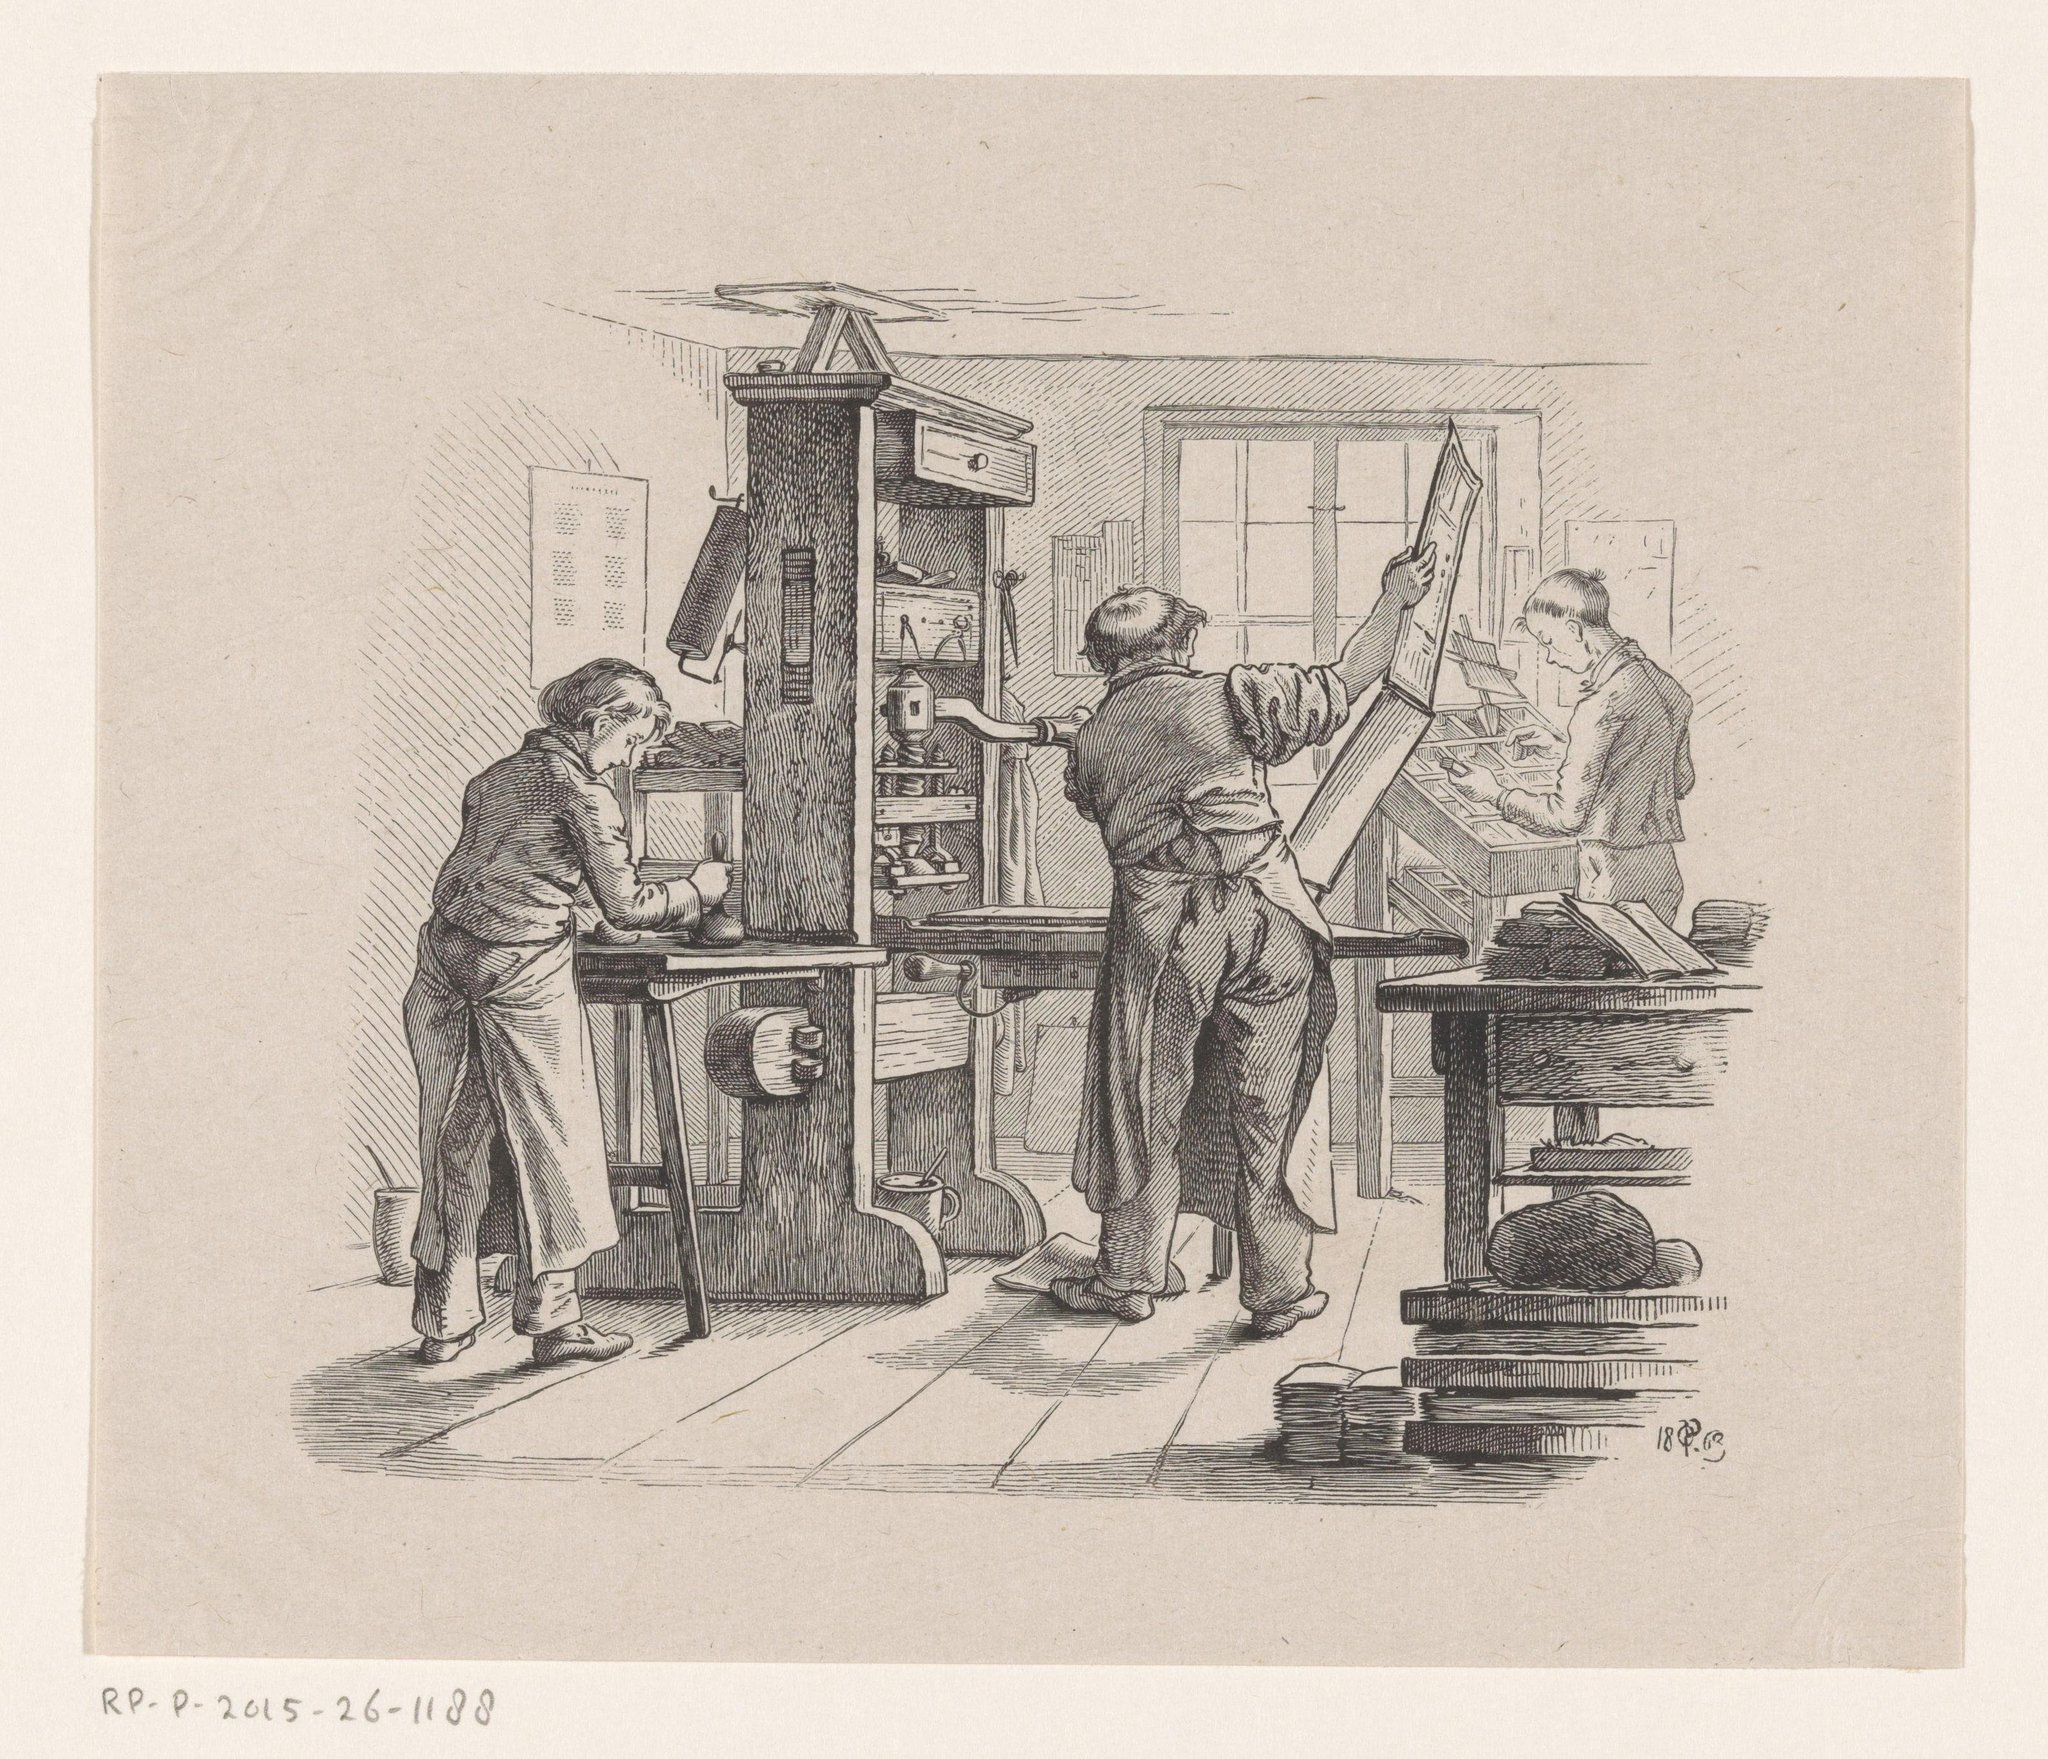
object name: print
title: Interieur van een boekdrukkerij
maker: monogrammist op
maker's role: print maker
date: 1863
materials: paper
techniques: engraving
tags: printing press, tools, implements of printer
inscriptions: collector's mark: Lugt 2228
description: Interieur van een boekdrukkerij met in het midden de drukker achter de pers. Op de voorgrond staat een leerling met een inkttampon. In de achtergrond voor het raam staat een leerling voor een letterkast.